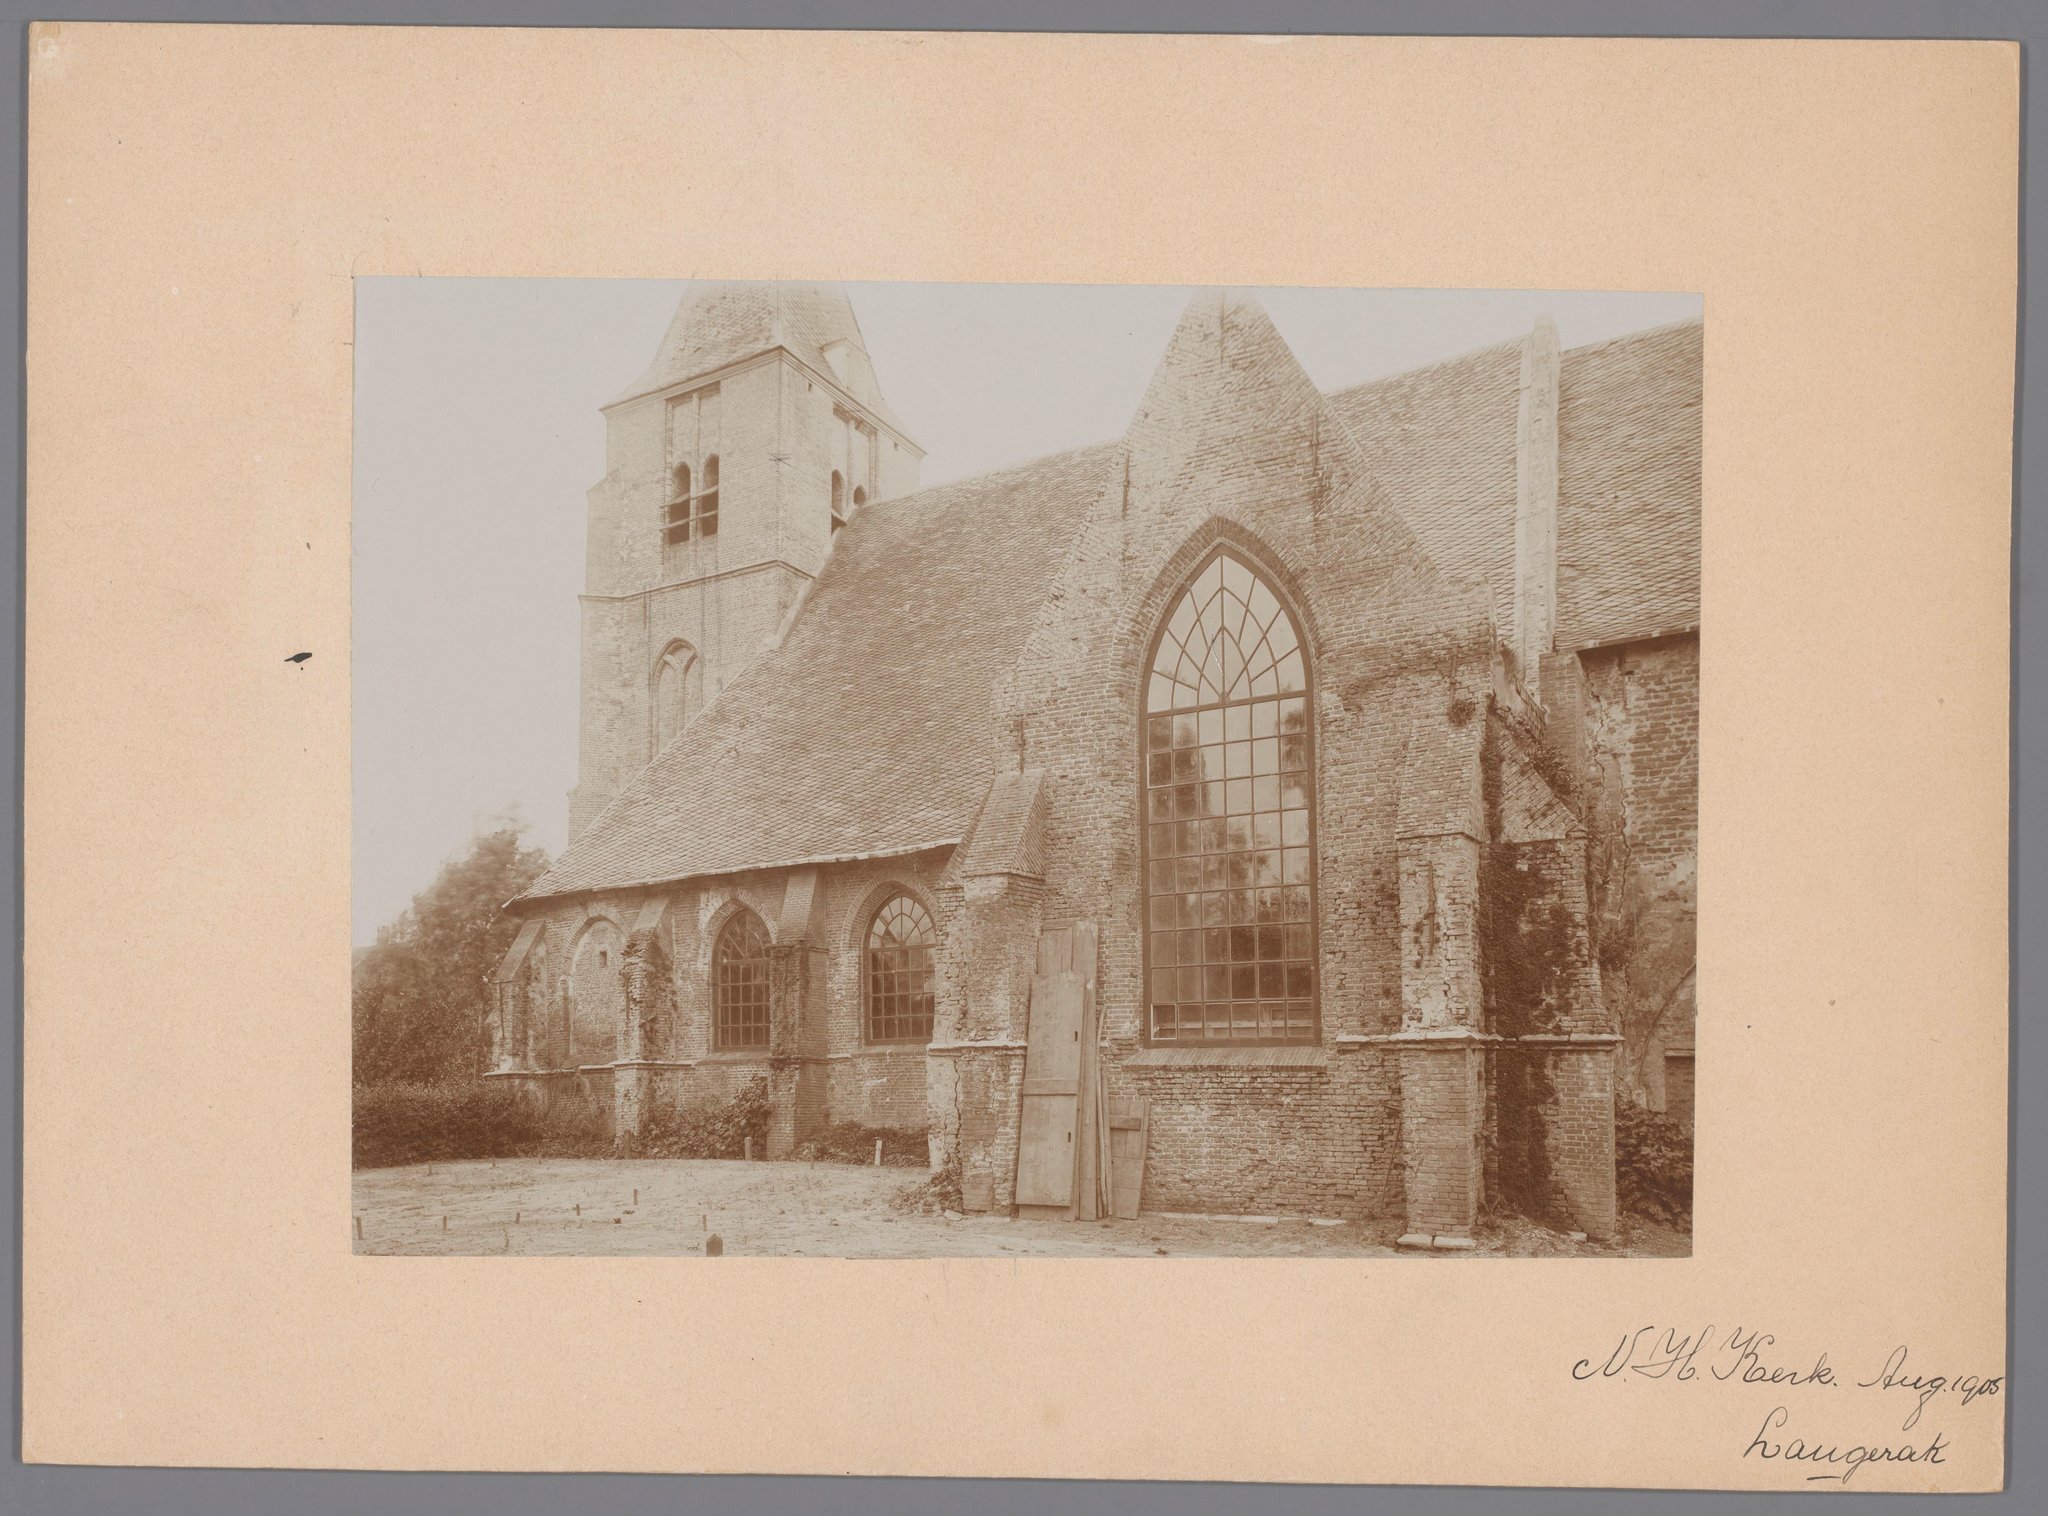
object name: photograph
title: Gezicht op de Hervormde Kerk te Langerak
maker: anoniem (monumentenzorg)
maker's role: fotograaf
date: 1905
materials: cardboard, photographic support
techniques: collodion silver print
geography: langerak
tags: church (exterior), langerak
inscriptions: annotation: ‘Langerak. Z.H. N.H. Kerk. Aug:1905’, annotation: ‘N.H. Kerk. Aug 1905/ Langerak’